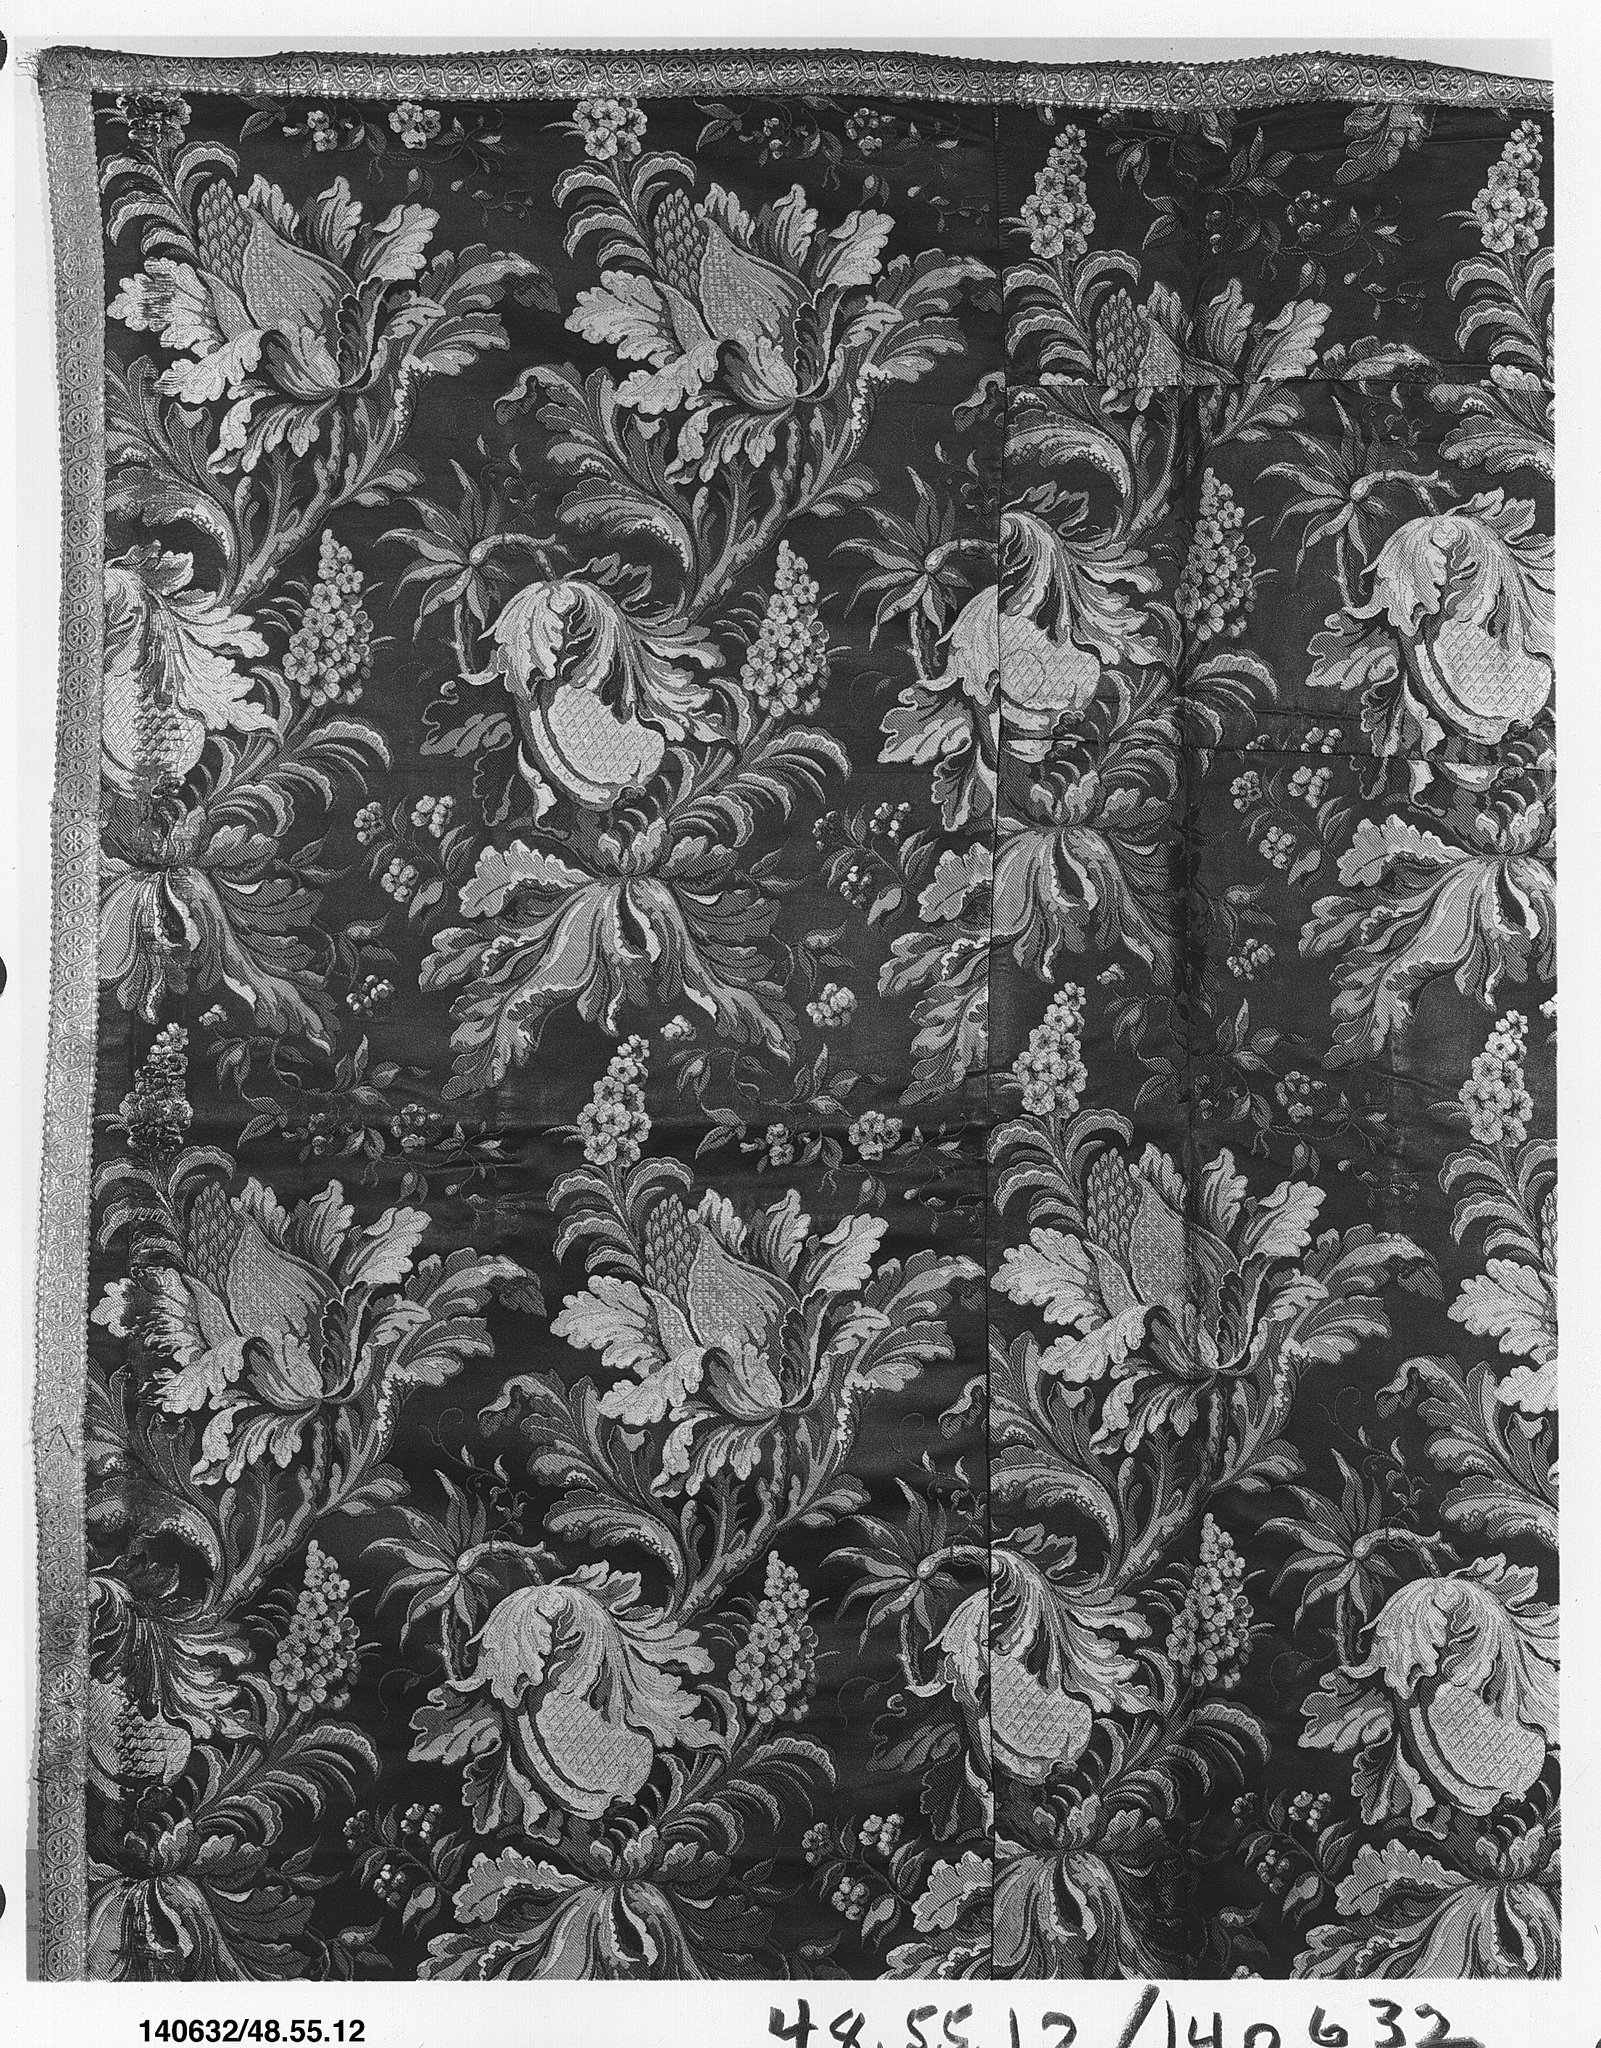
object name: piece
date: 1851-1900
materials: silk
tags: flowers,leaves